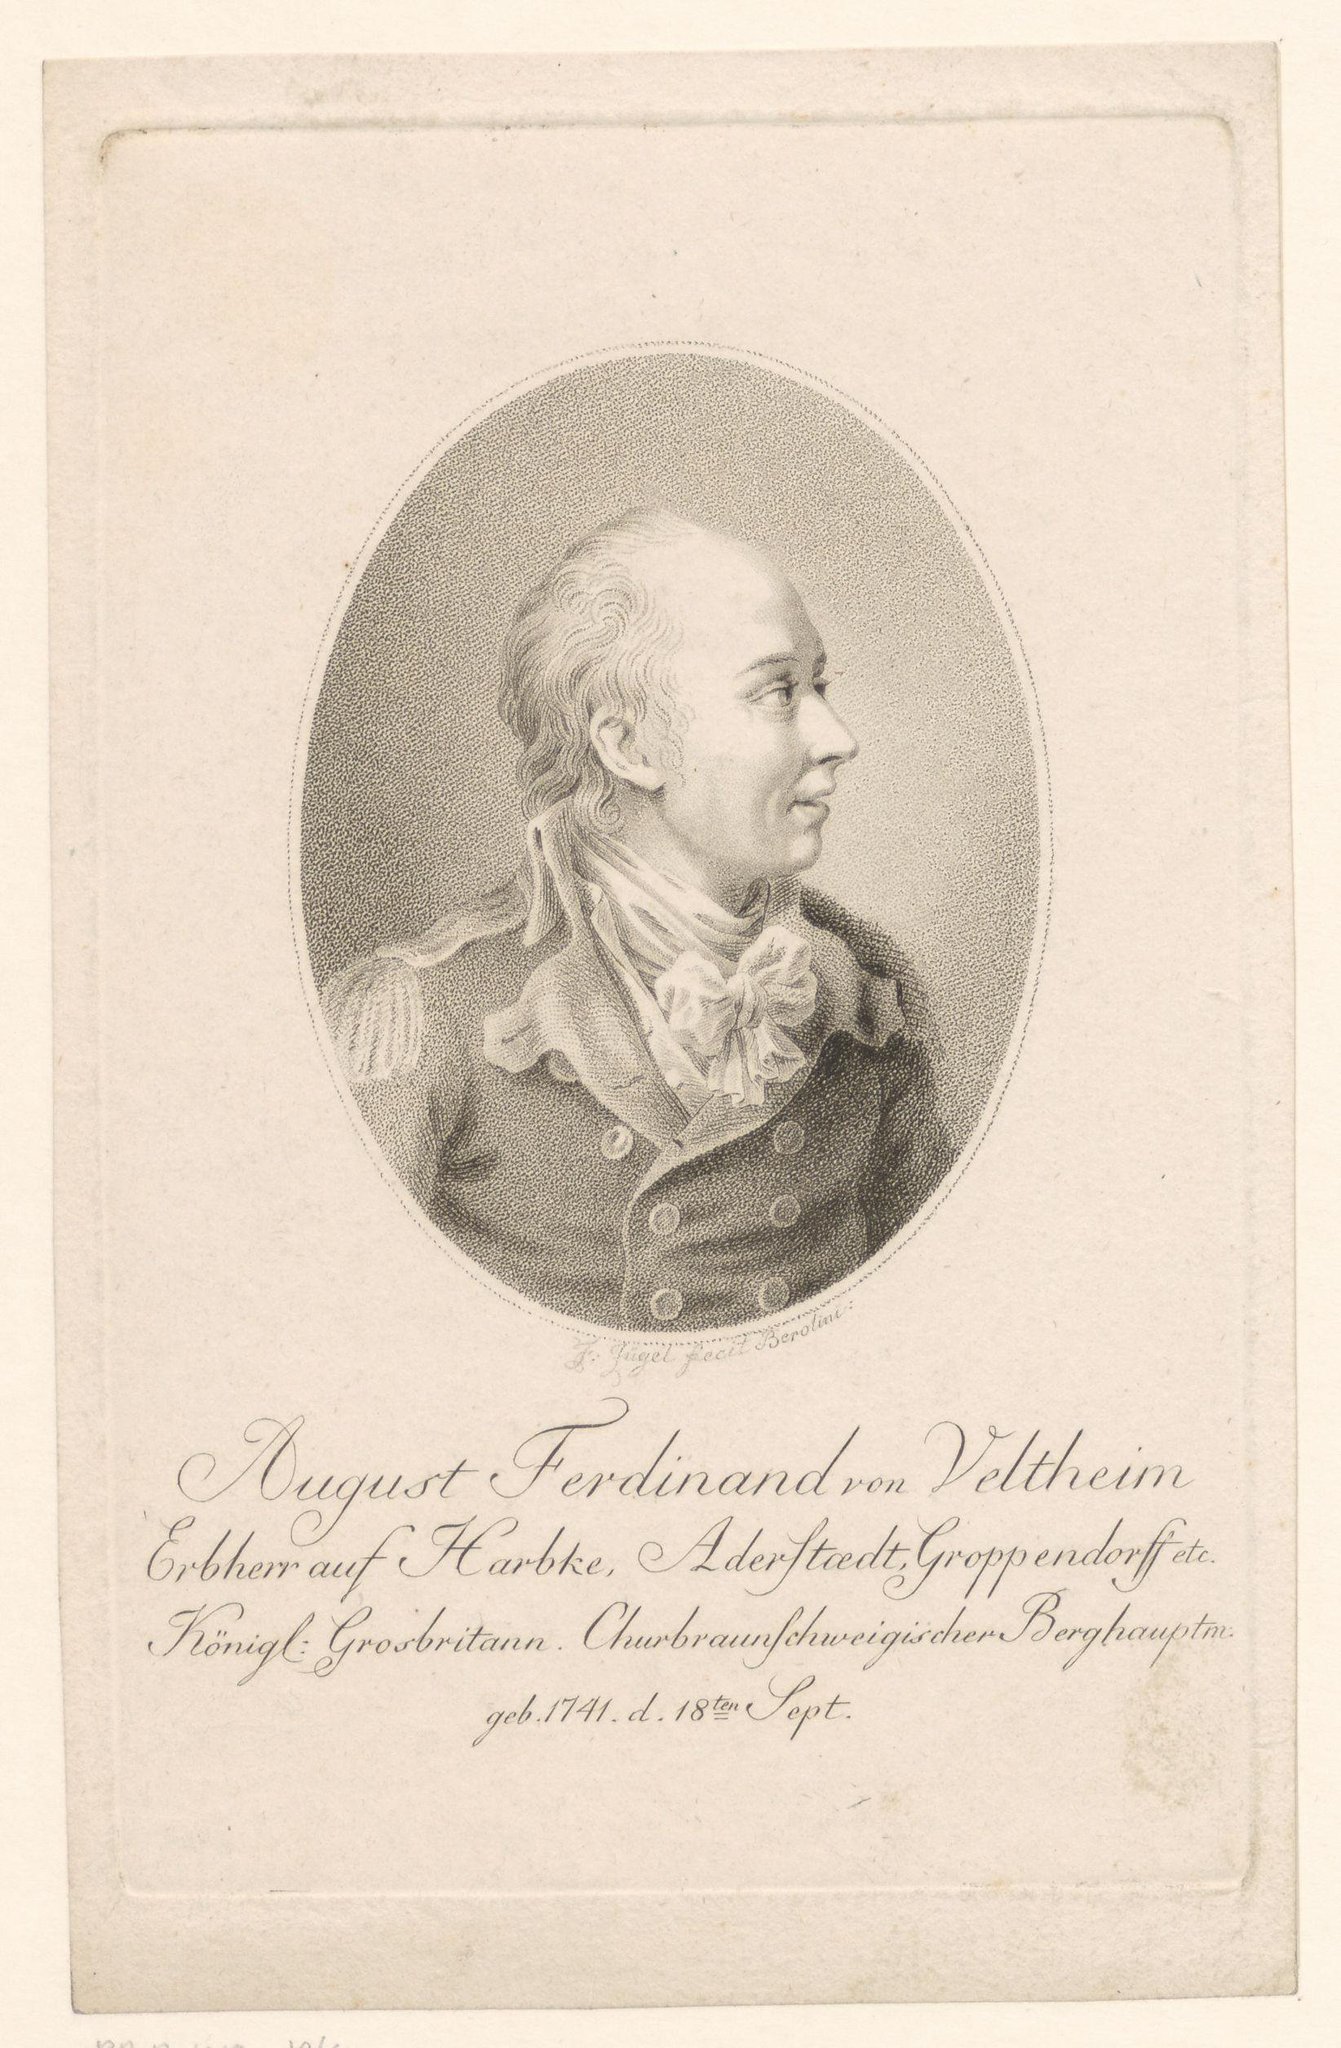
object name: print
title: Portret van August Ferdinand von Veltheim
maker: friedrich jügel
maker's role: print maker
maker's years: 1772-1833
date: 1782-1833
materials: paper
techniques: stippling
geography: berlin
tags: historical persons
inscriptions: collector's mark: Lugt 2228